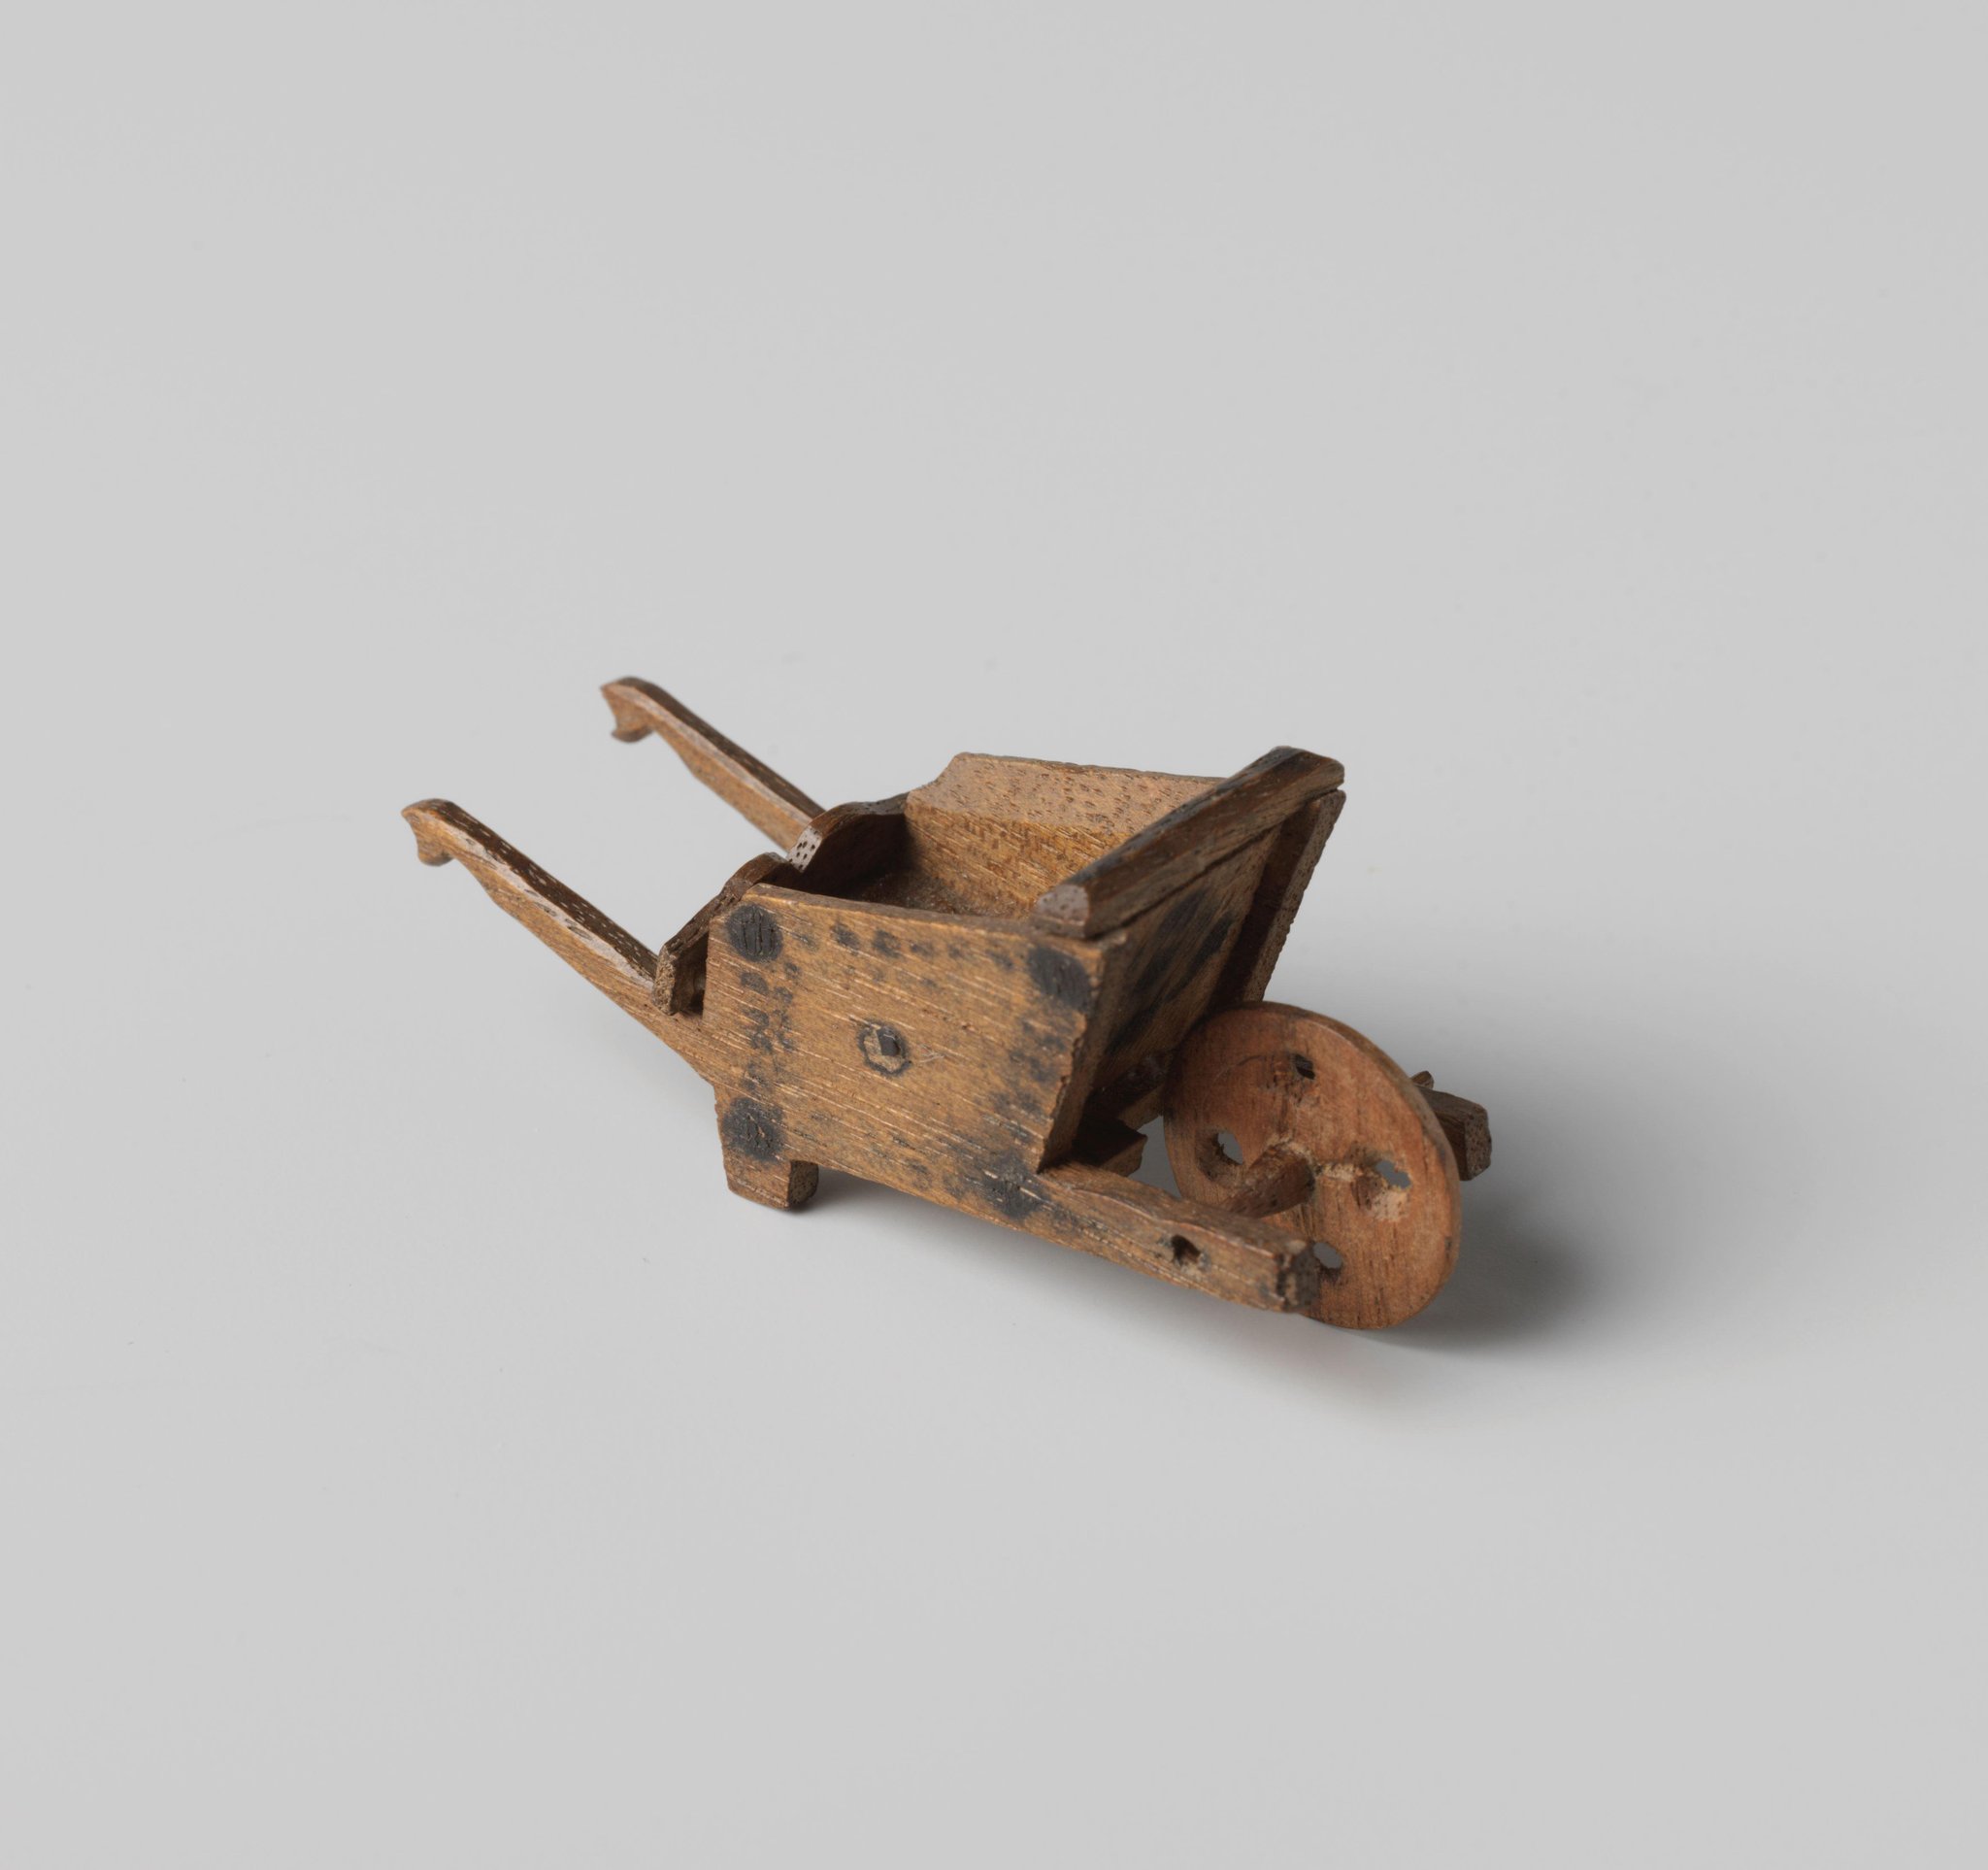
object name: miniature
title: Kruiwagen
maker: Anonymous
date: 1700-1799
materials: wood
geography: amsterdam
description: Kruiwagen van donker gebeitst notenhout met witte stippen en vier gaten in het wiel.